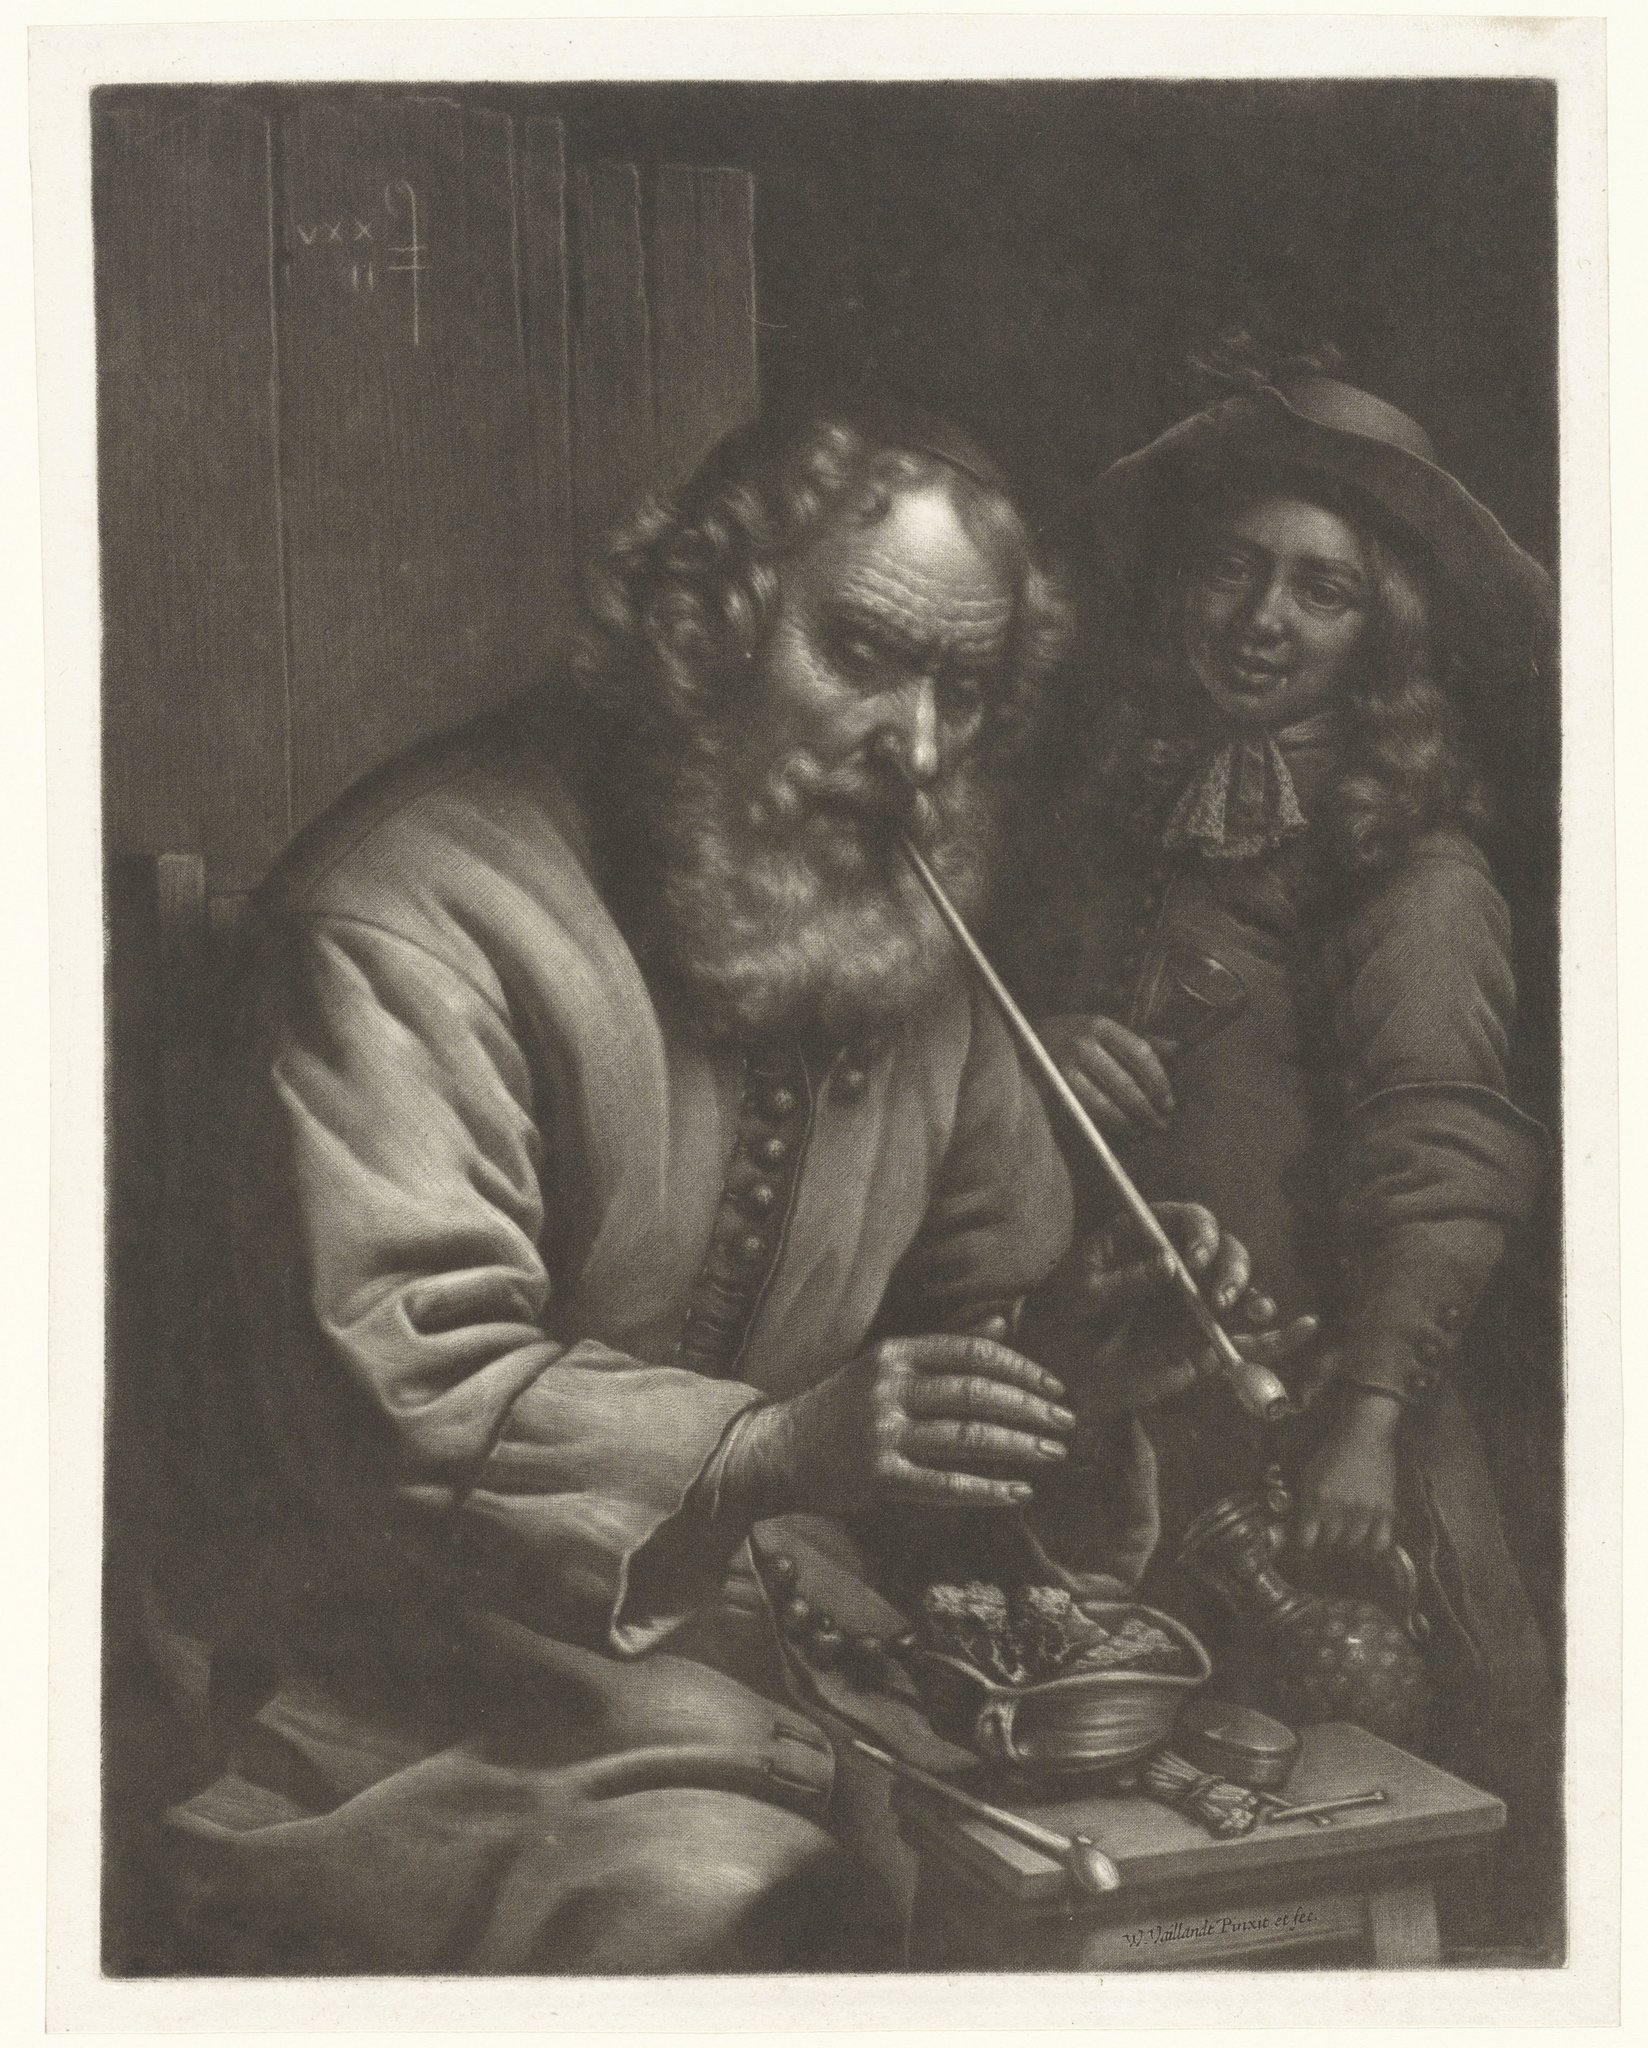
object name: print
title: Rokende oude man warmt zijn handen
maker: wallerant vaillant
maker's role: draughtsman, painter, print maker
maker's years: 1623-1677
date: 1658-1677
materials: paper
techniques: mezzotint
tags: warming oneself at a fire (or hearth, stove, fire-pan, brazier), pipe ~ tobacco, old man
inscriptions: collector's mark: Lugt 10, collector's mark: Lugt 11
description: Een pijprokende oude man warmt zijn handen aan een potje. Schuin achter hem staat een glimlachende jongen met een kan en een glas in zijn hand.